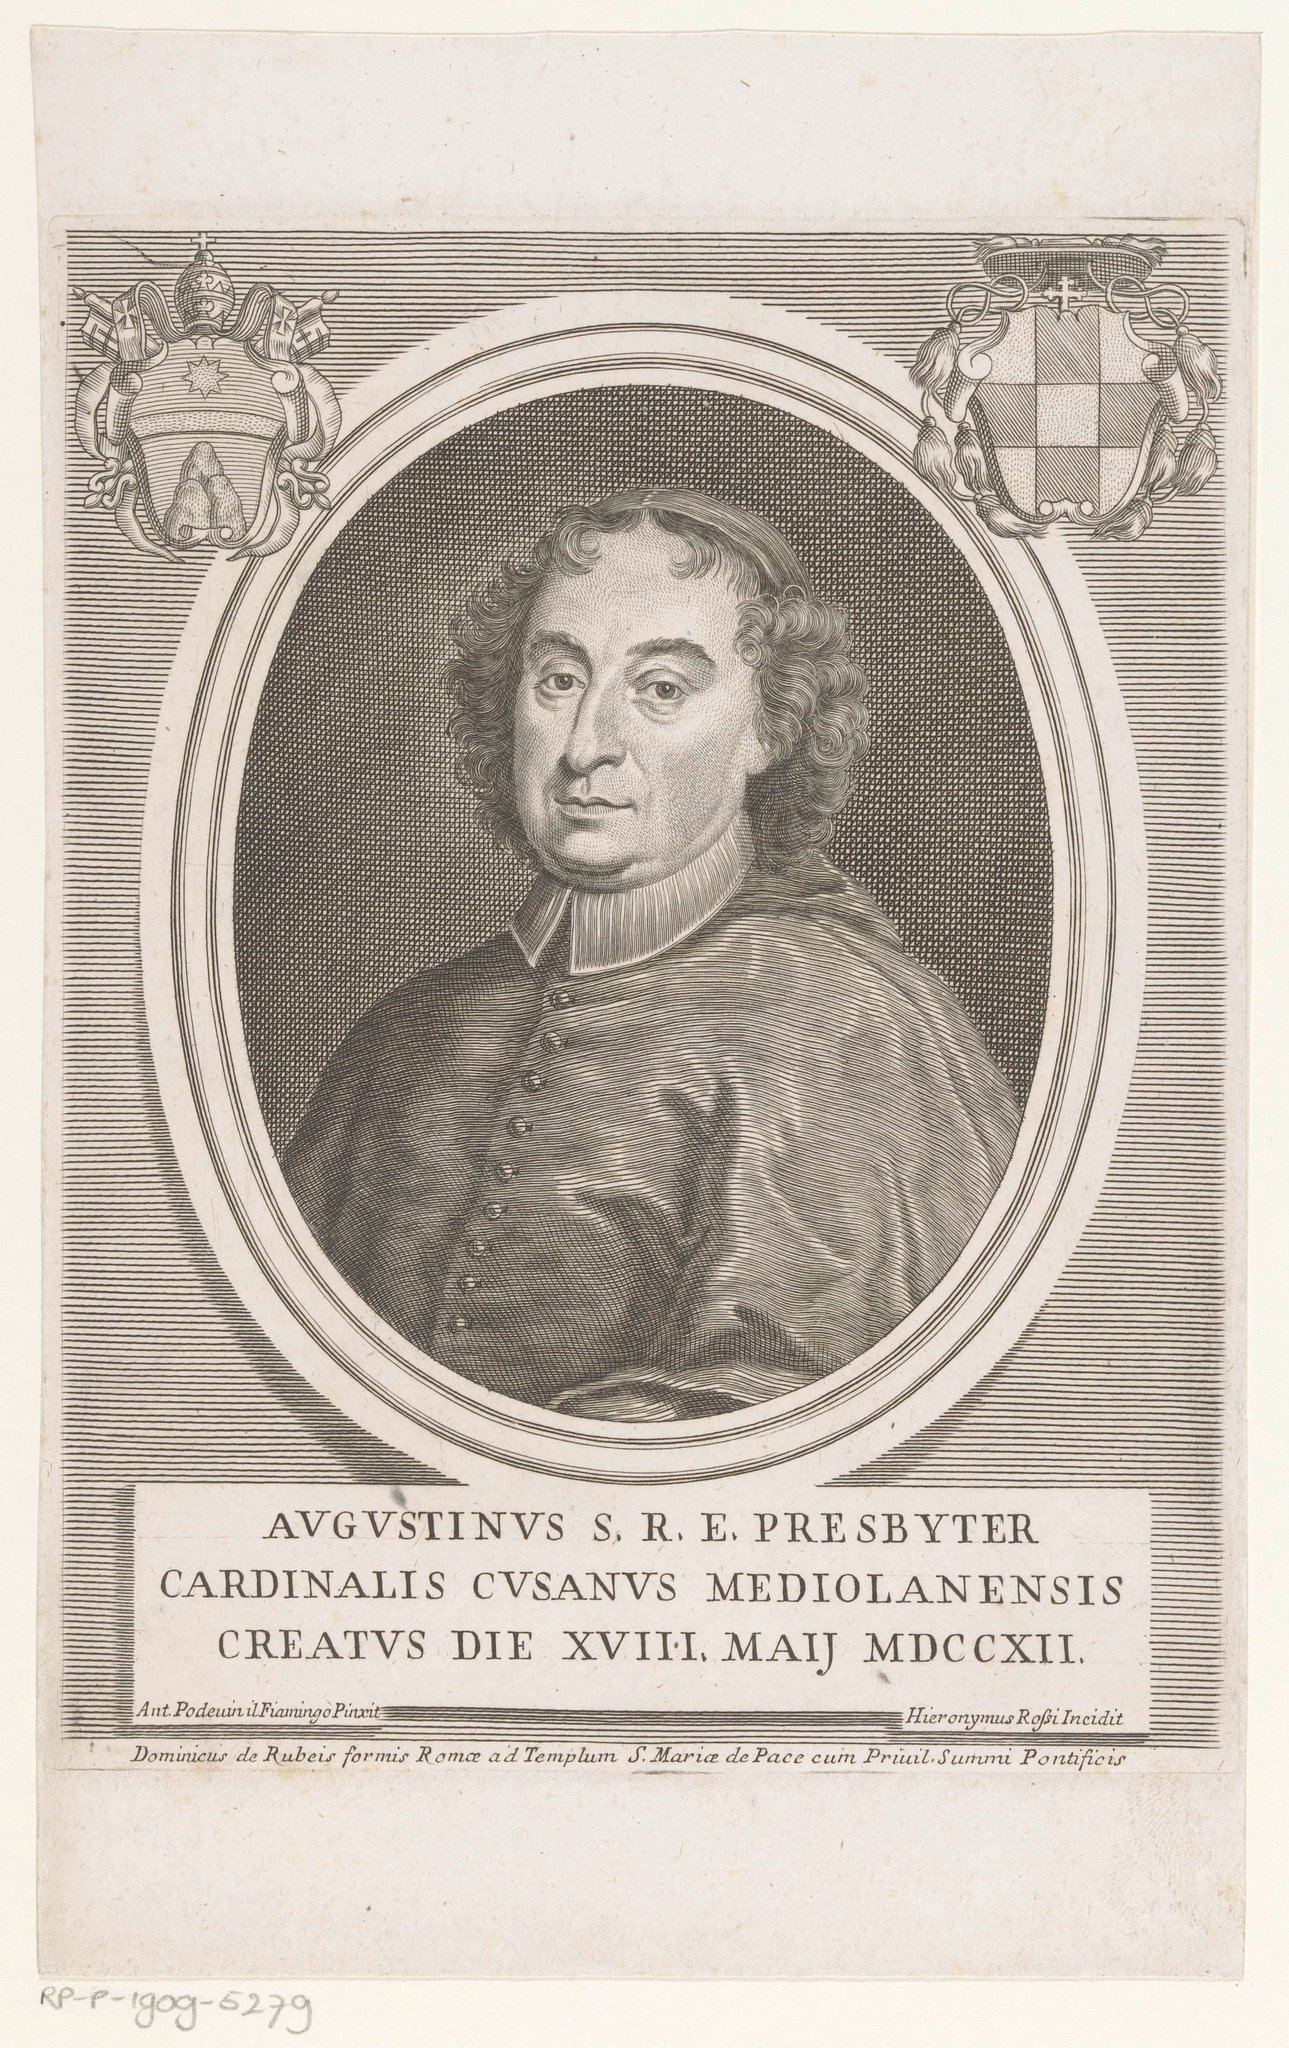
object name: print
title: Portret van kardinaal Agostino Cusani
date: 1712-1762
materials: paper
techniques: engraving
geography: rome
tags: cardinal, historical persons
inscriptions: collector's mark: Lugt 2228